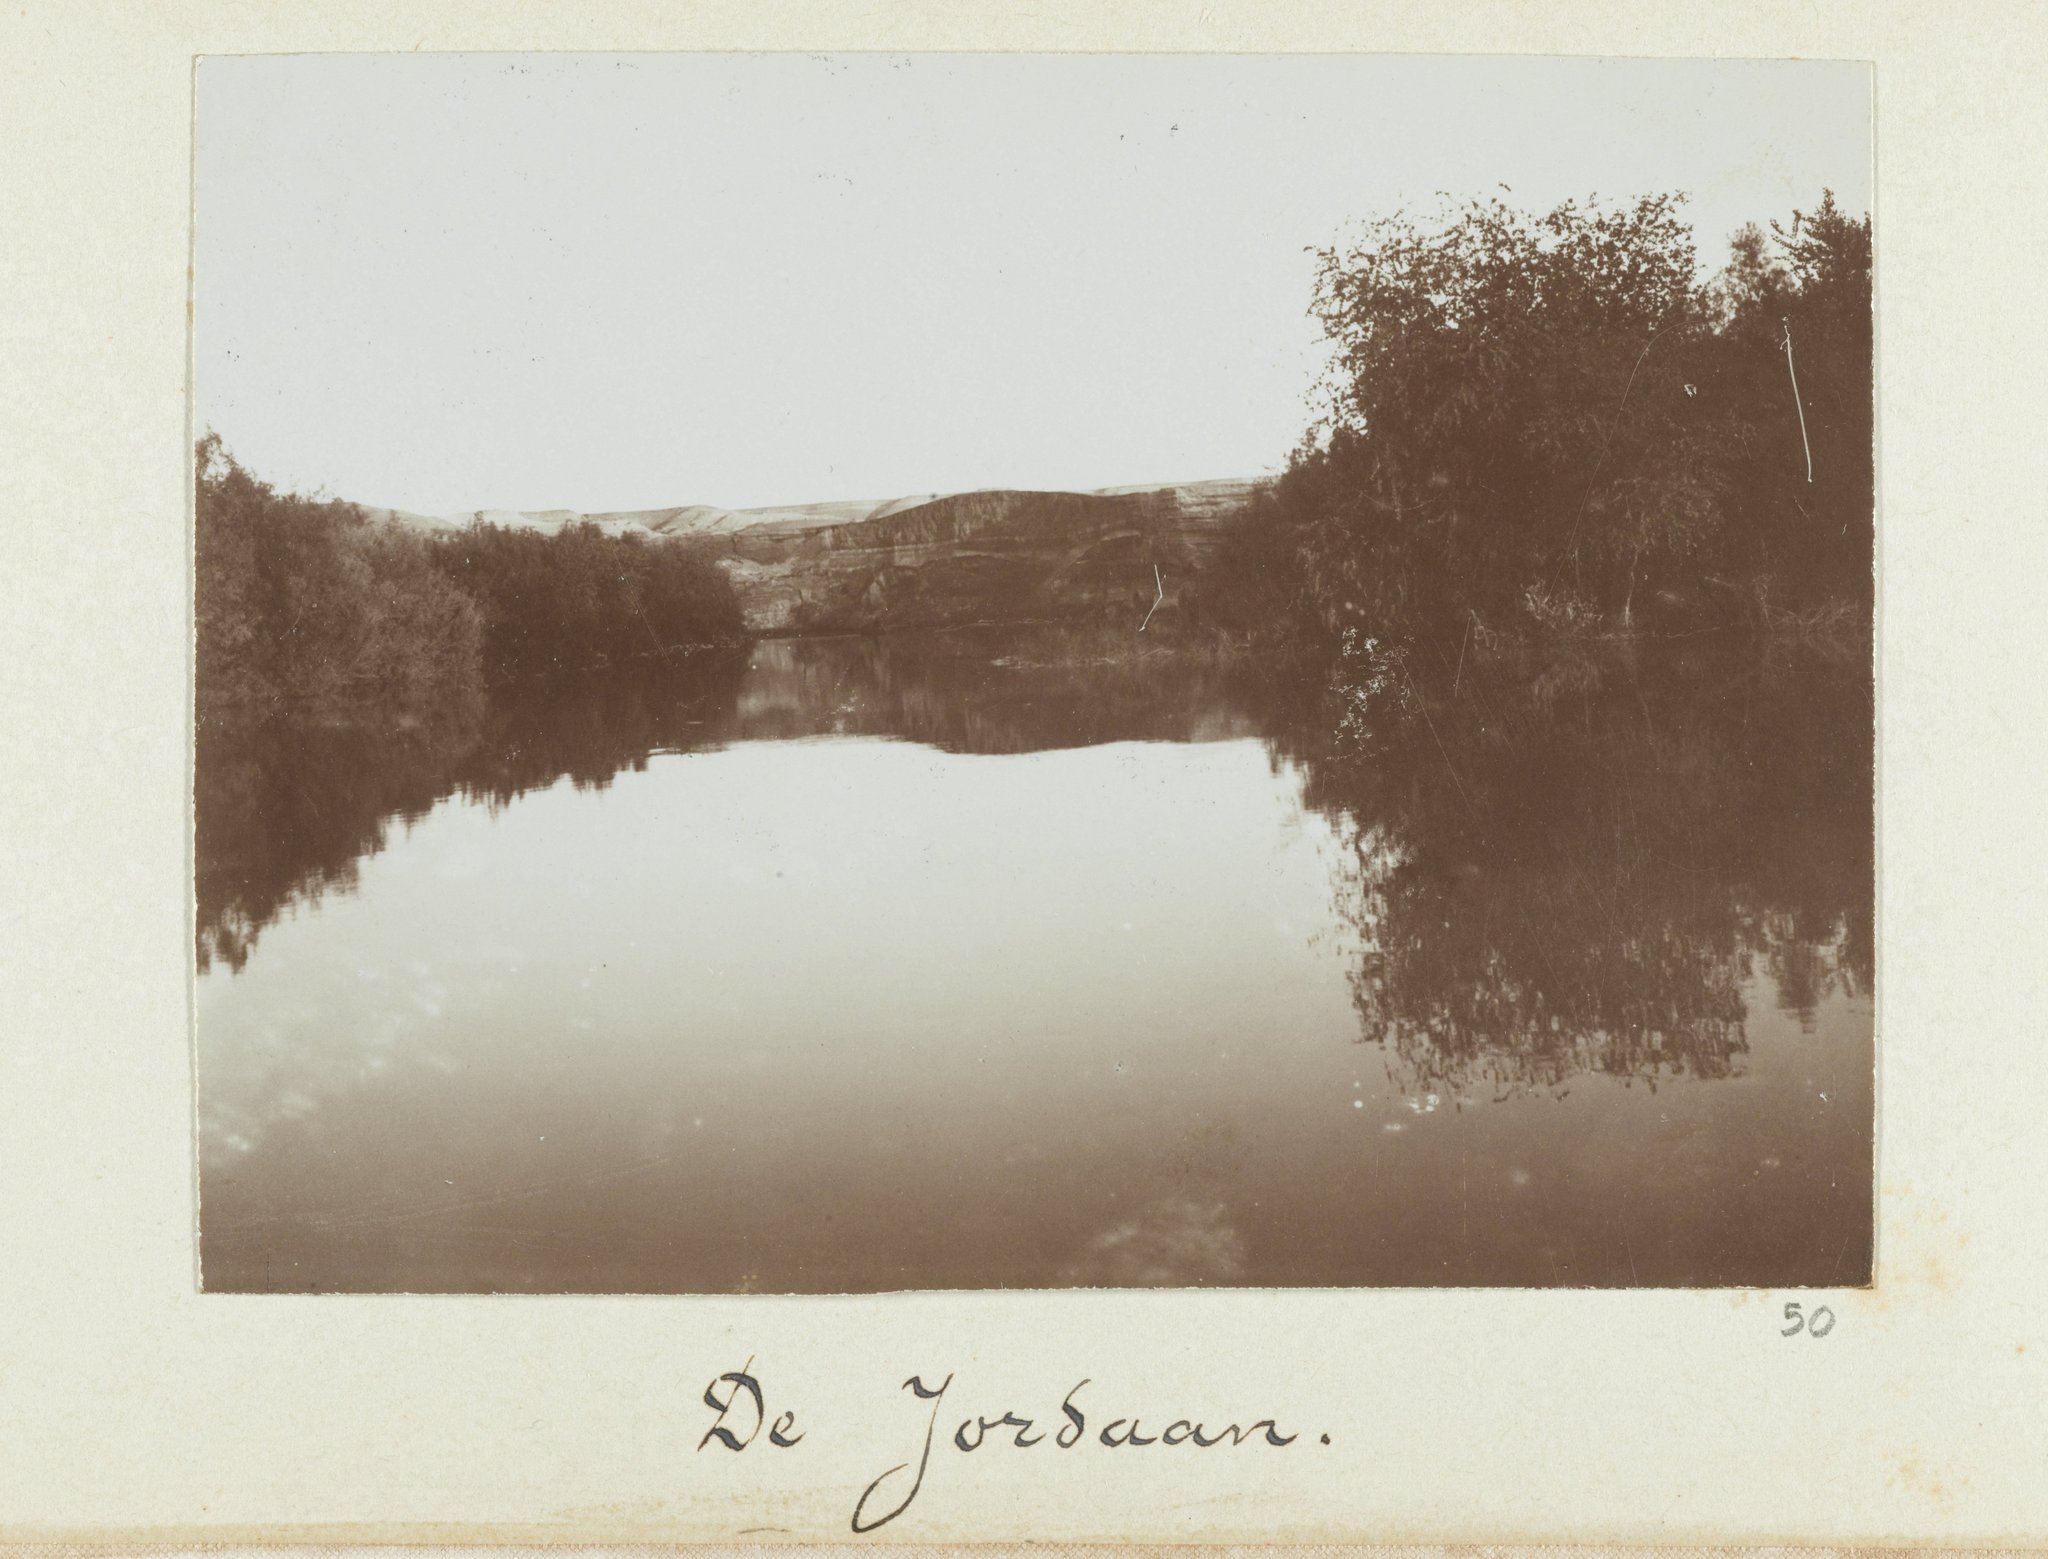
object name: page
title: De Jordaan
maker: johannes lodewijk heldring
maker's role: fotograaf, predikant, schrijver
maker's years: 1852-1923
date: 1898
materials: paper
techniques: collodion silver print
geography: west bank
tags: river